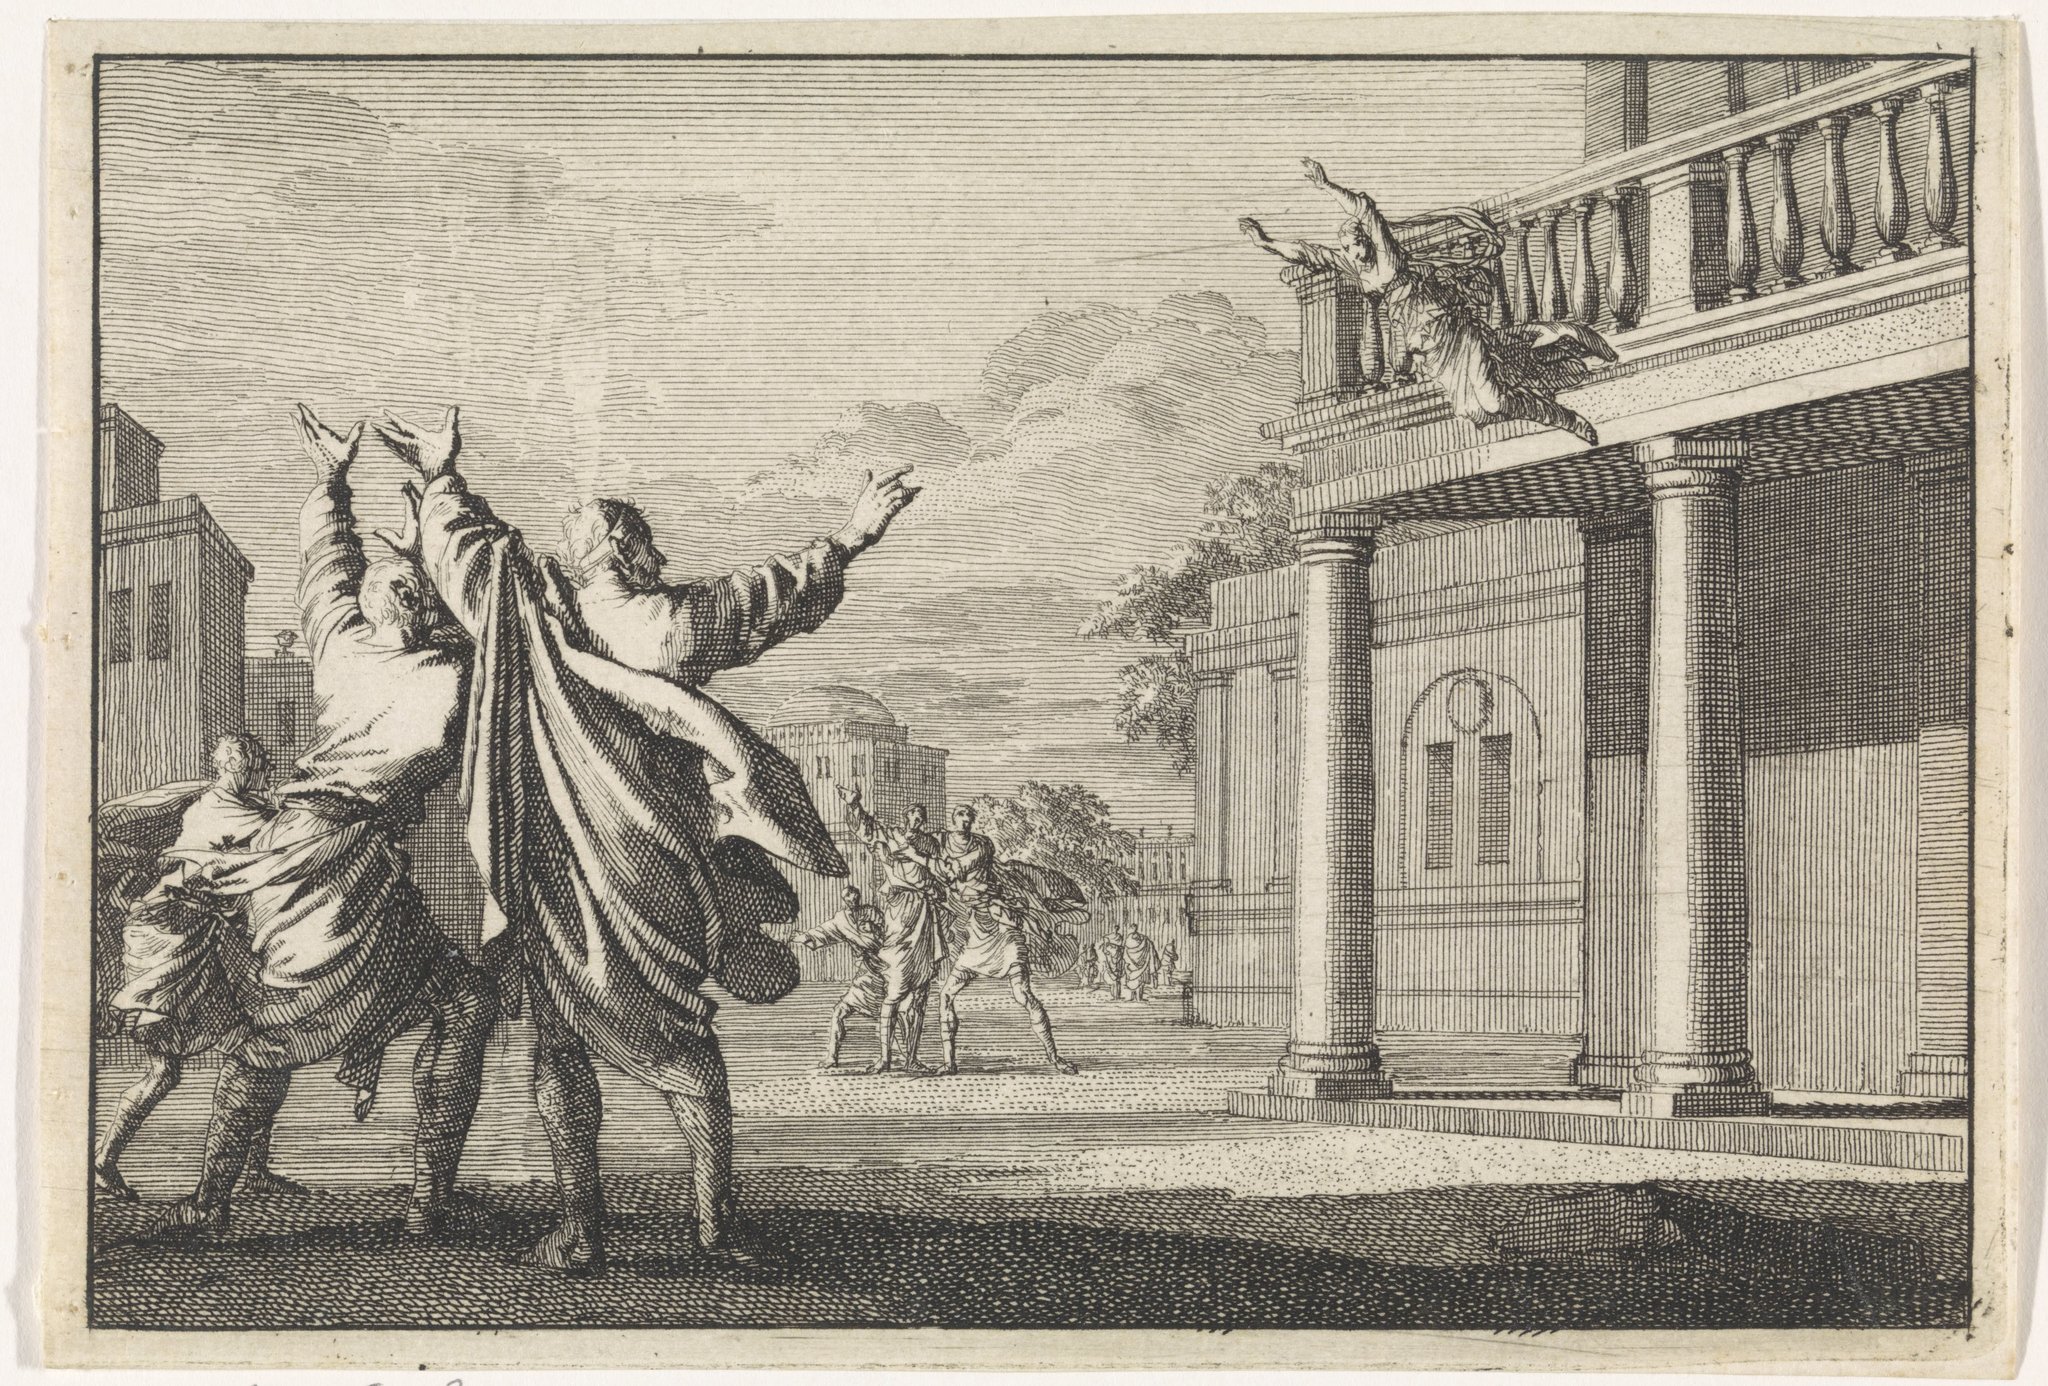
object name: print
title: Weduwe van Pheroras probeert zelfmoord te plegen door zich op straat te werpen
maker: jan luyken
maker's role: draughtsman, print maker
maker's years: 1649-1712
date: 1704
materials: paper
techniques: etching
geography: amsterdam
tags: seeking death, suicide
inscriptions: collector's mark: Lugt 2228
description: Prent ook gebruikt als boekillustratie in: Josephus, Flavius. Alle de Werken, 2 delen. Amsterdam: Pieter Mortier, 1704, dl. 2, p. 552.